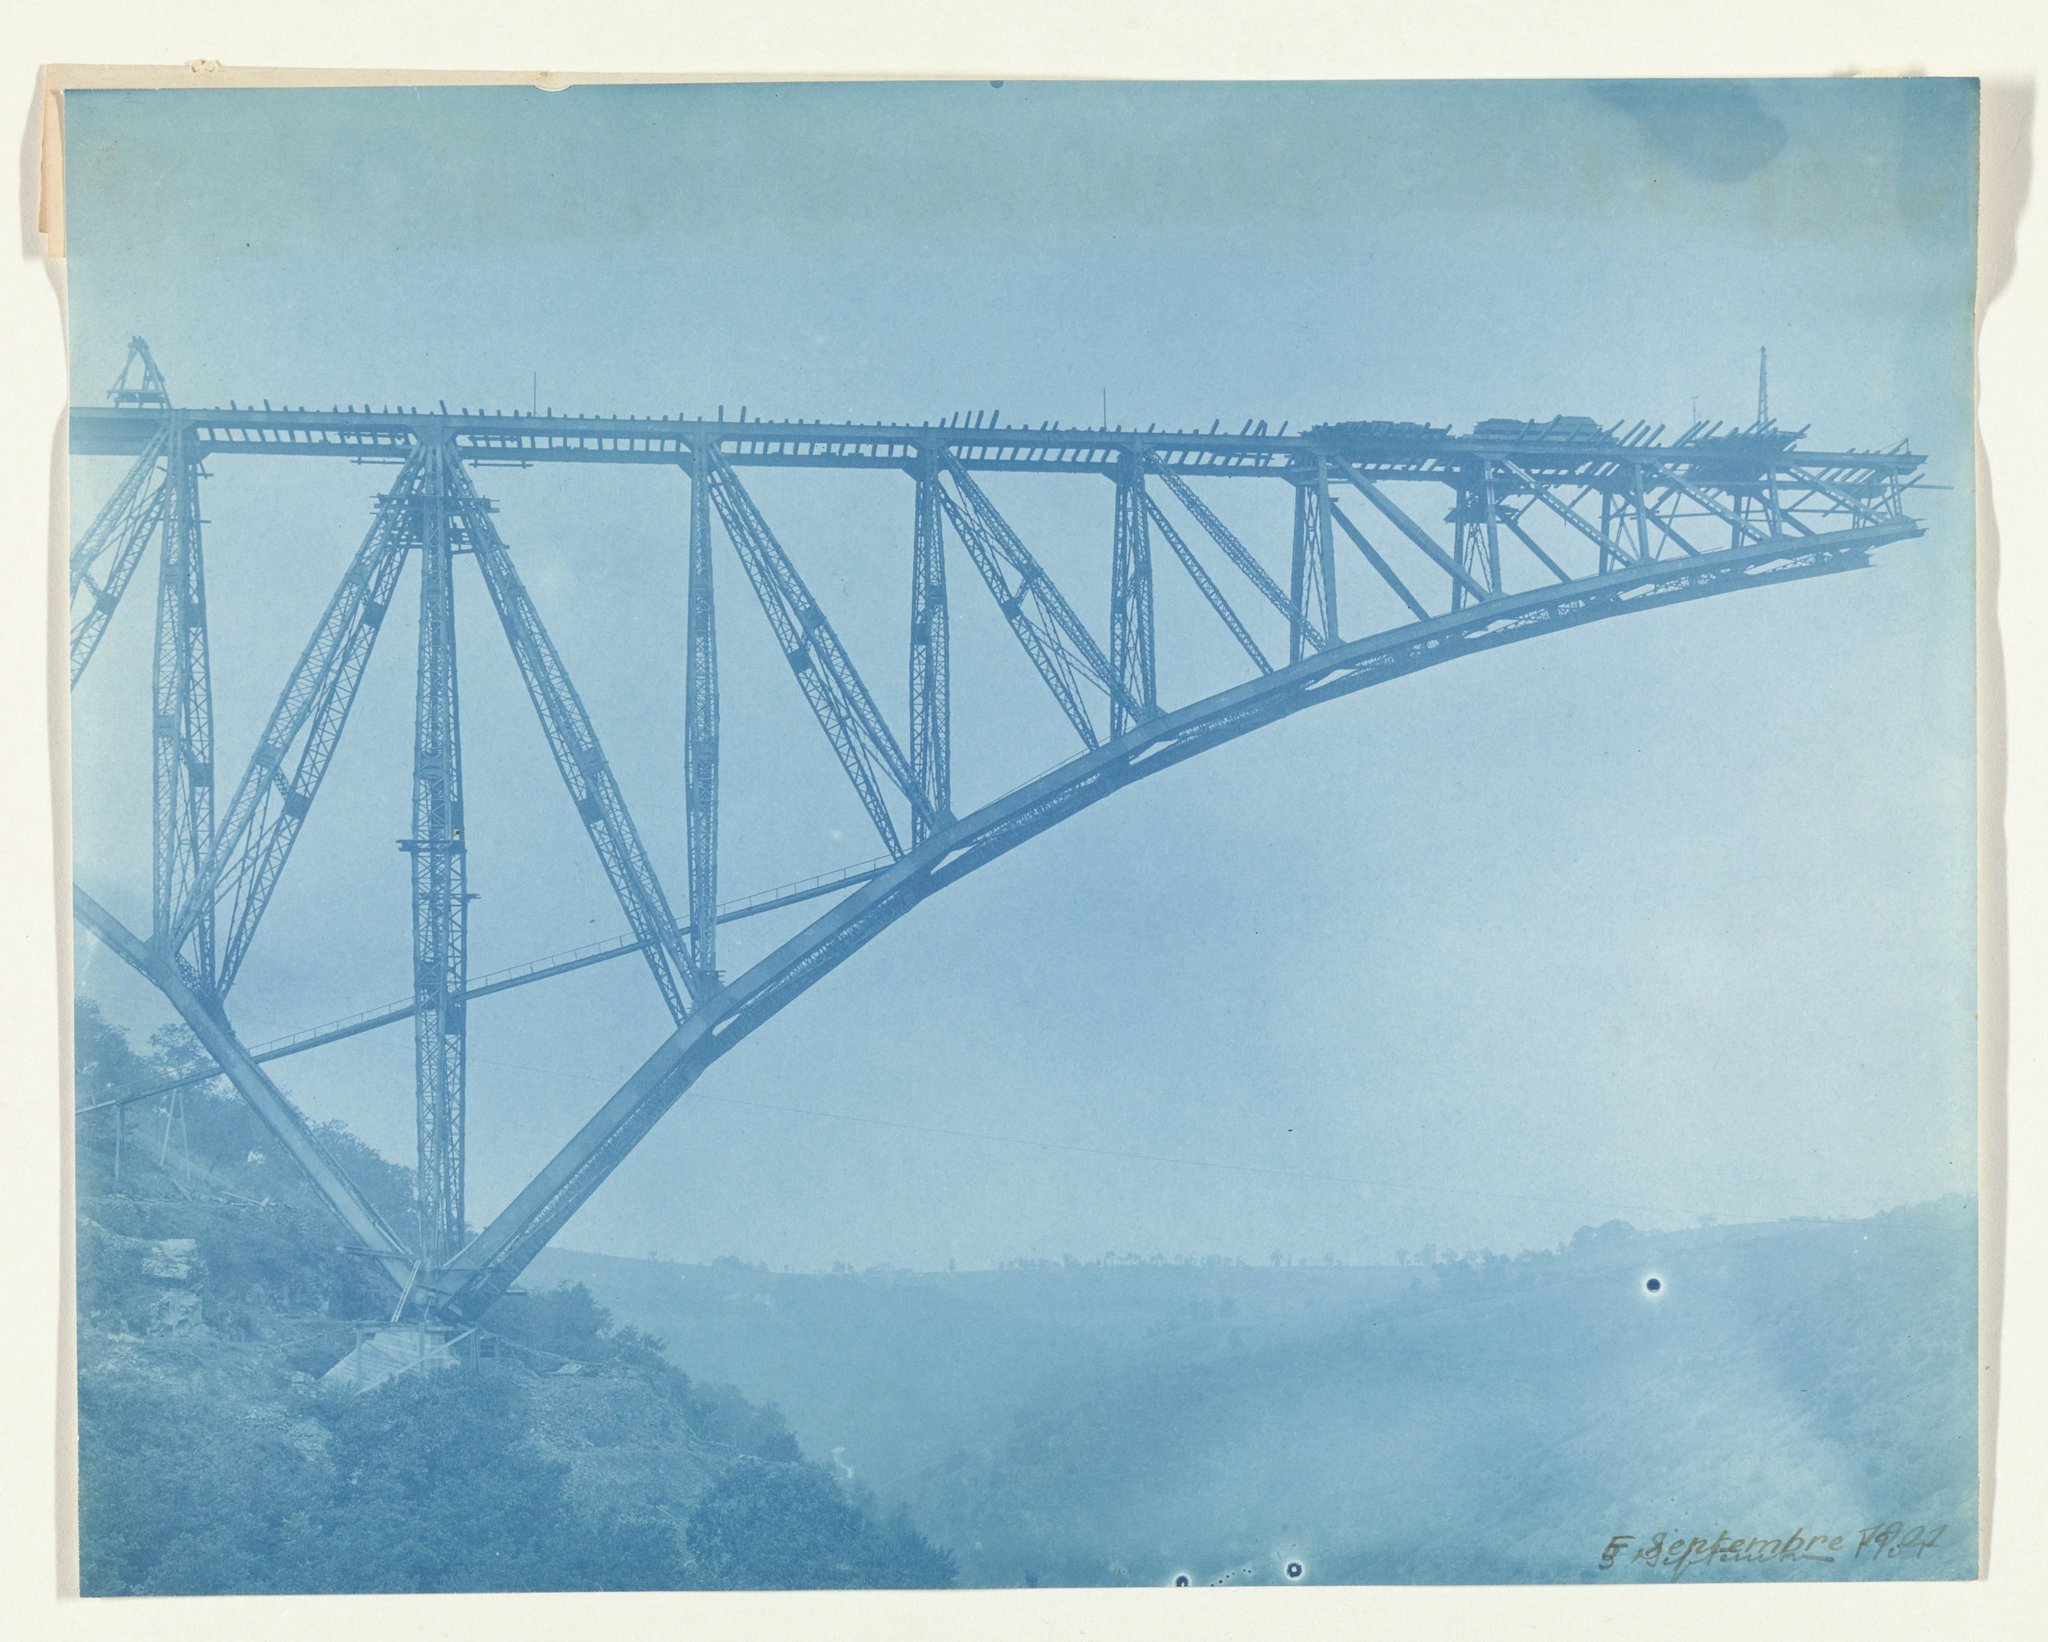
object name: photograph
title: Aanleg van het Viaur Viaduct in Frankrijk door de Societé de Construction des Battignolles, 5 september 1901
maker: Anonymous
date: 1901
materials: photographic support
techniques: cyanotype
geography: france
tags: viaduct, making the overground structures (~ building activities)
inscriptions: date